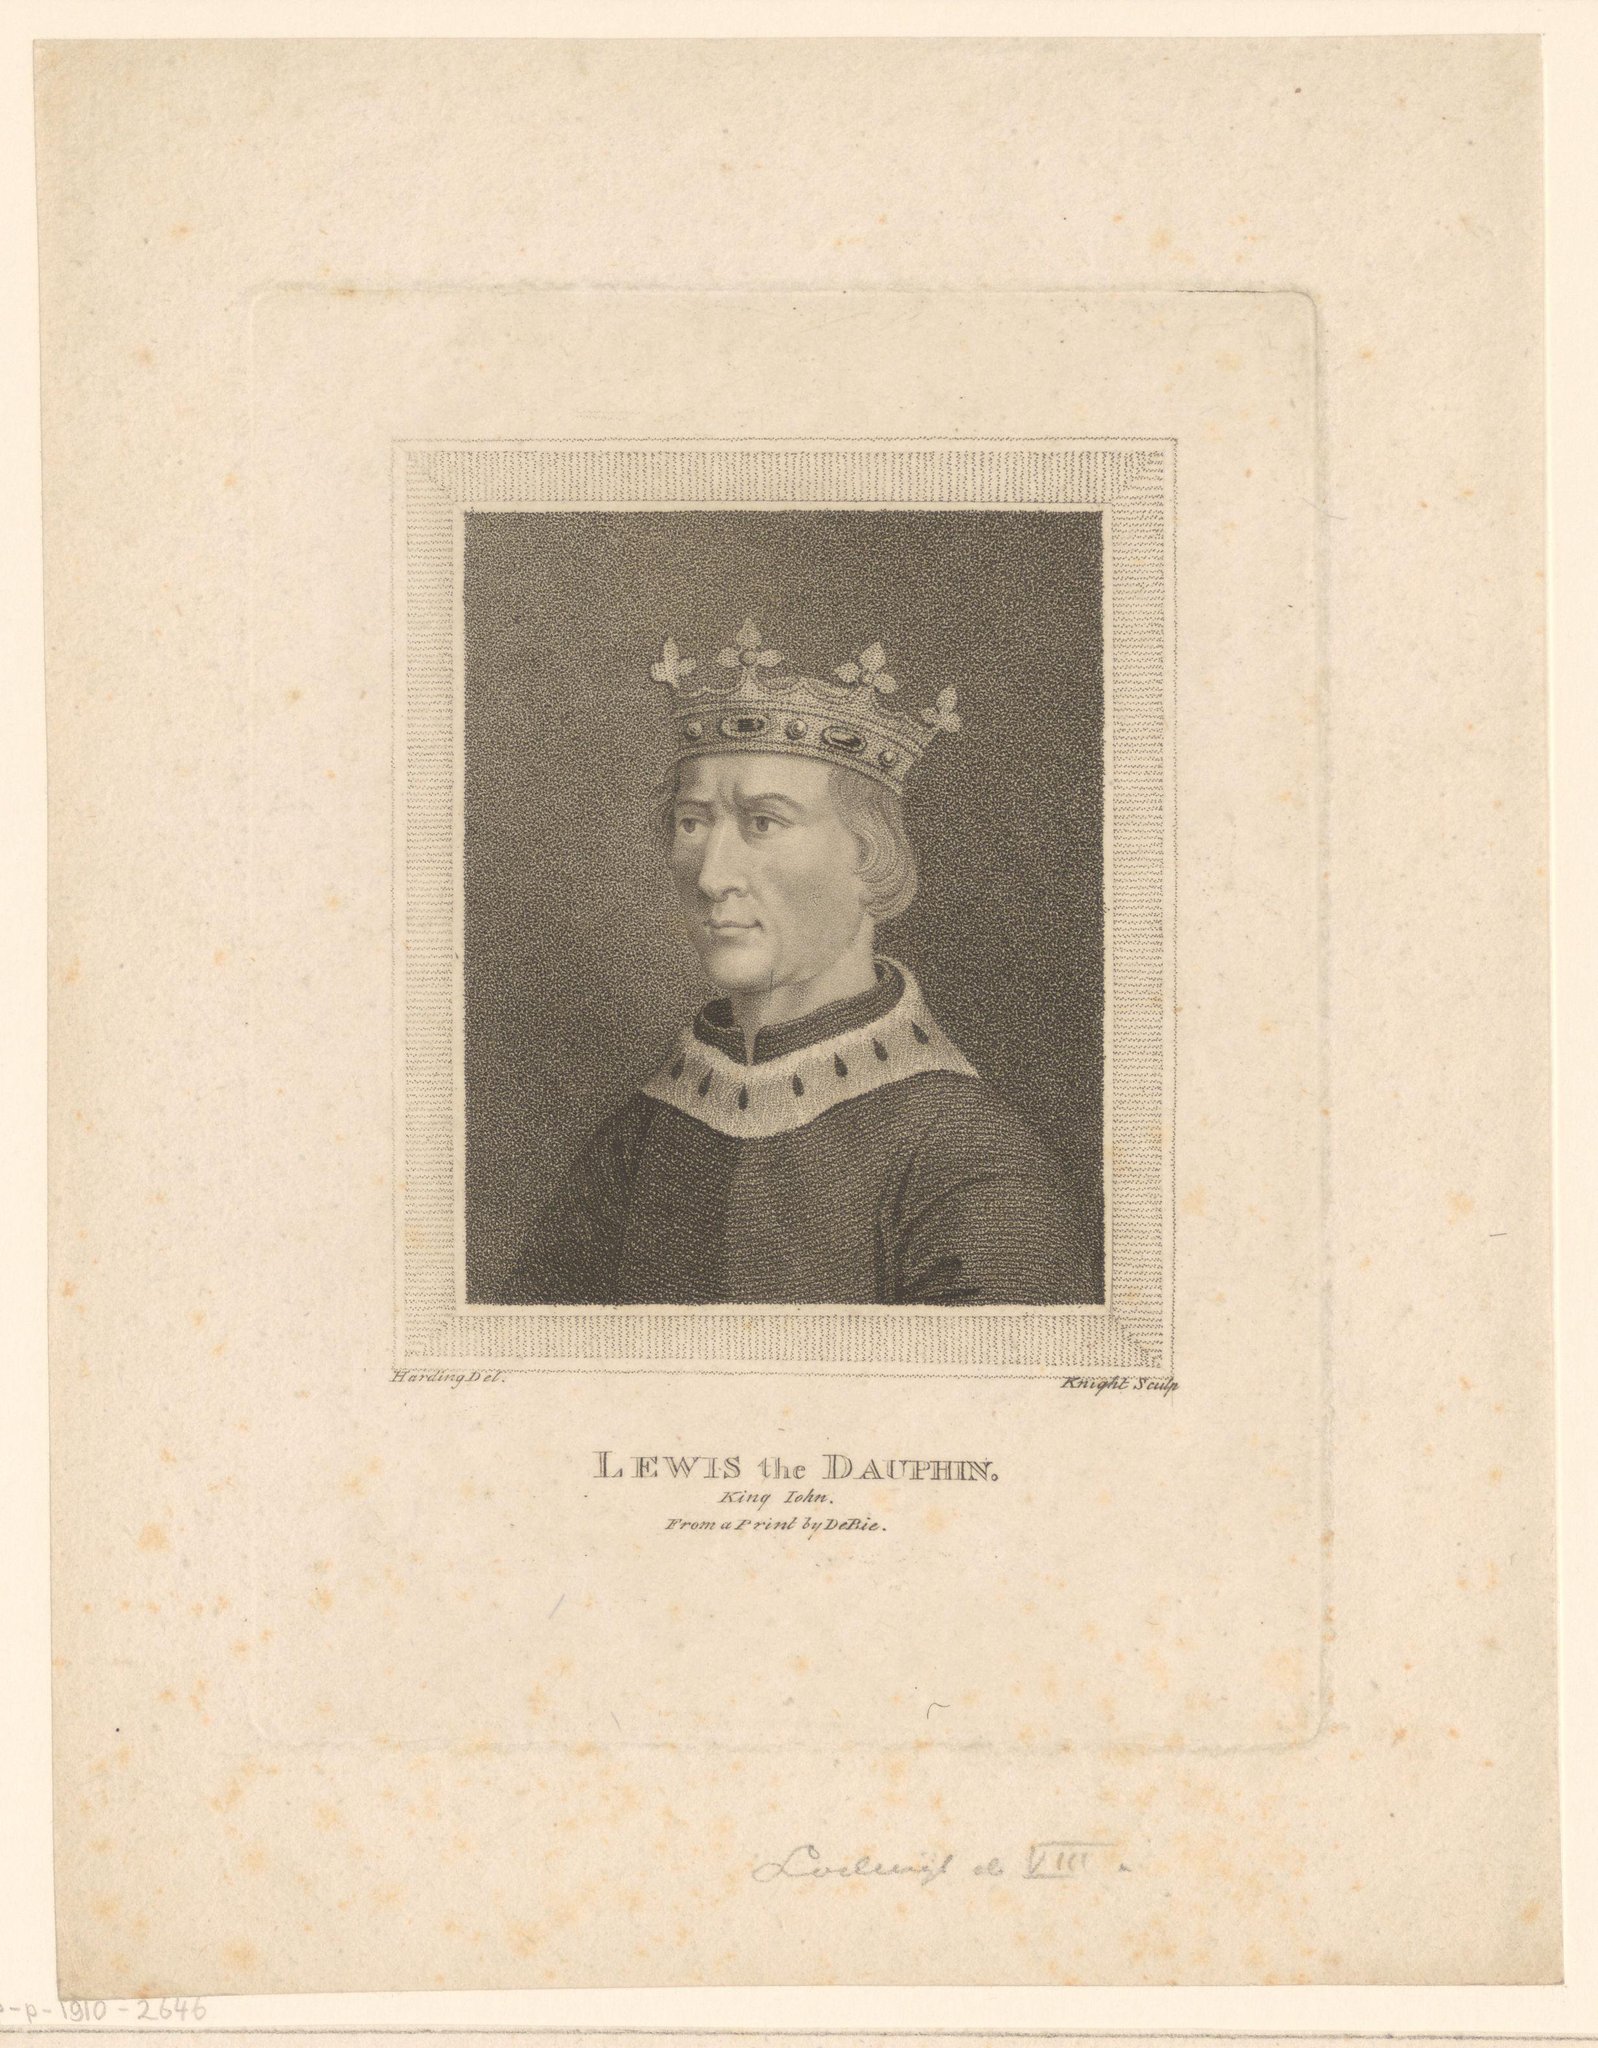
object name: print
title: Portret van Lodewijk VIII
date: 1753-1826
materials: paper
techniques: stippling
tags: paris, historical persons, king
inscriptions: collector's mark: Lugt 2228